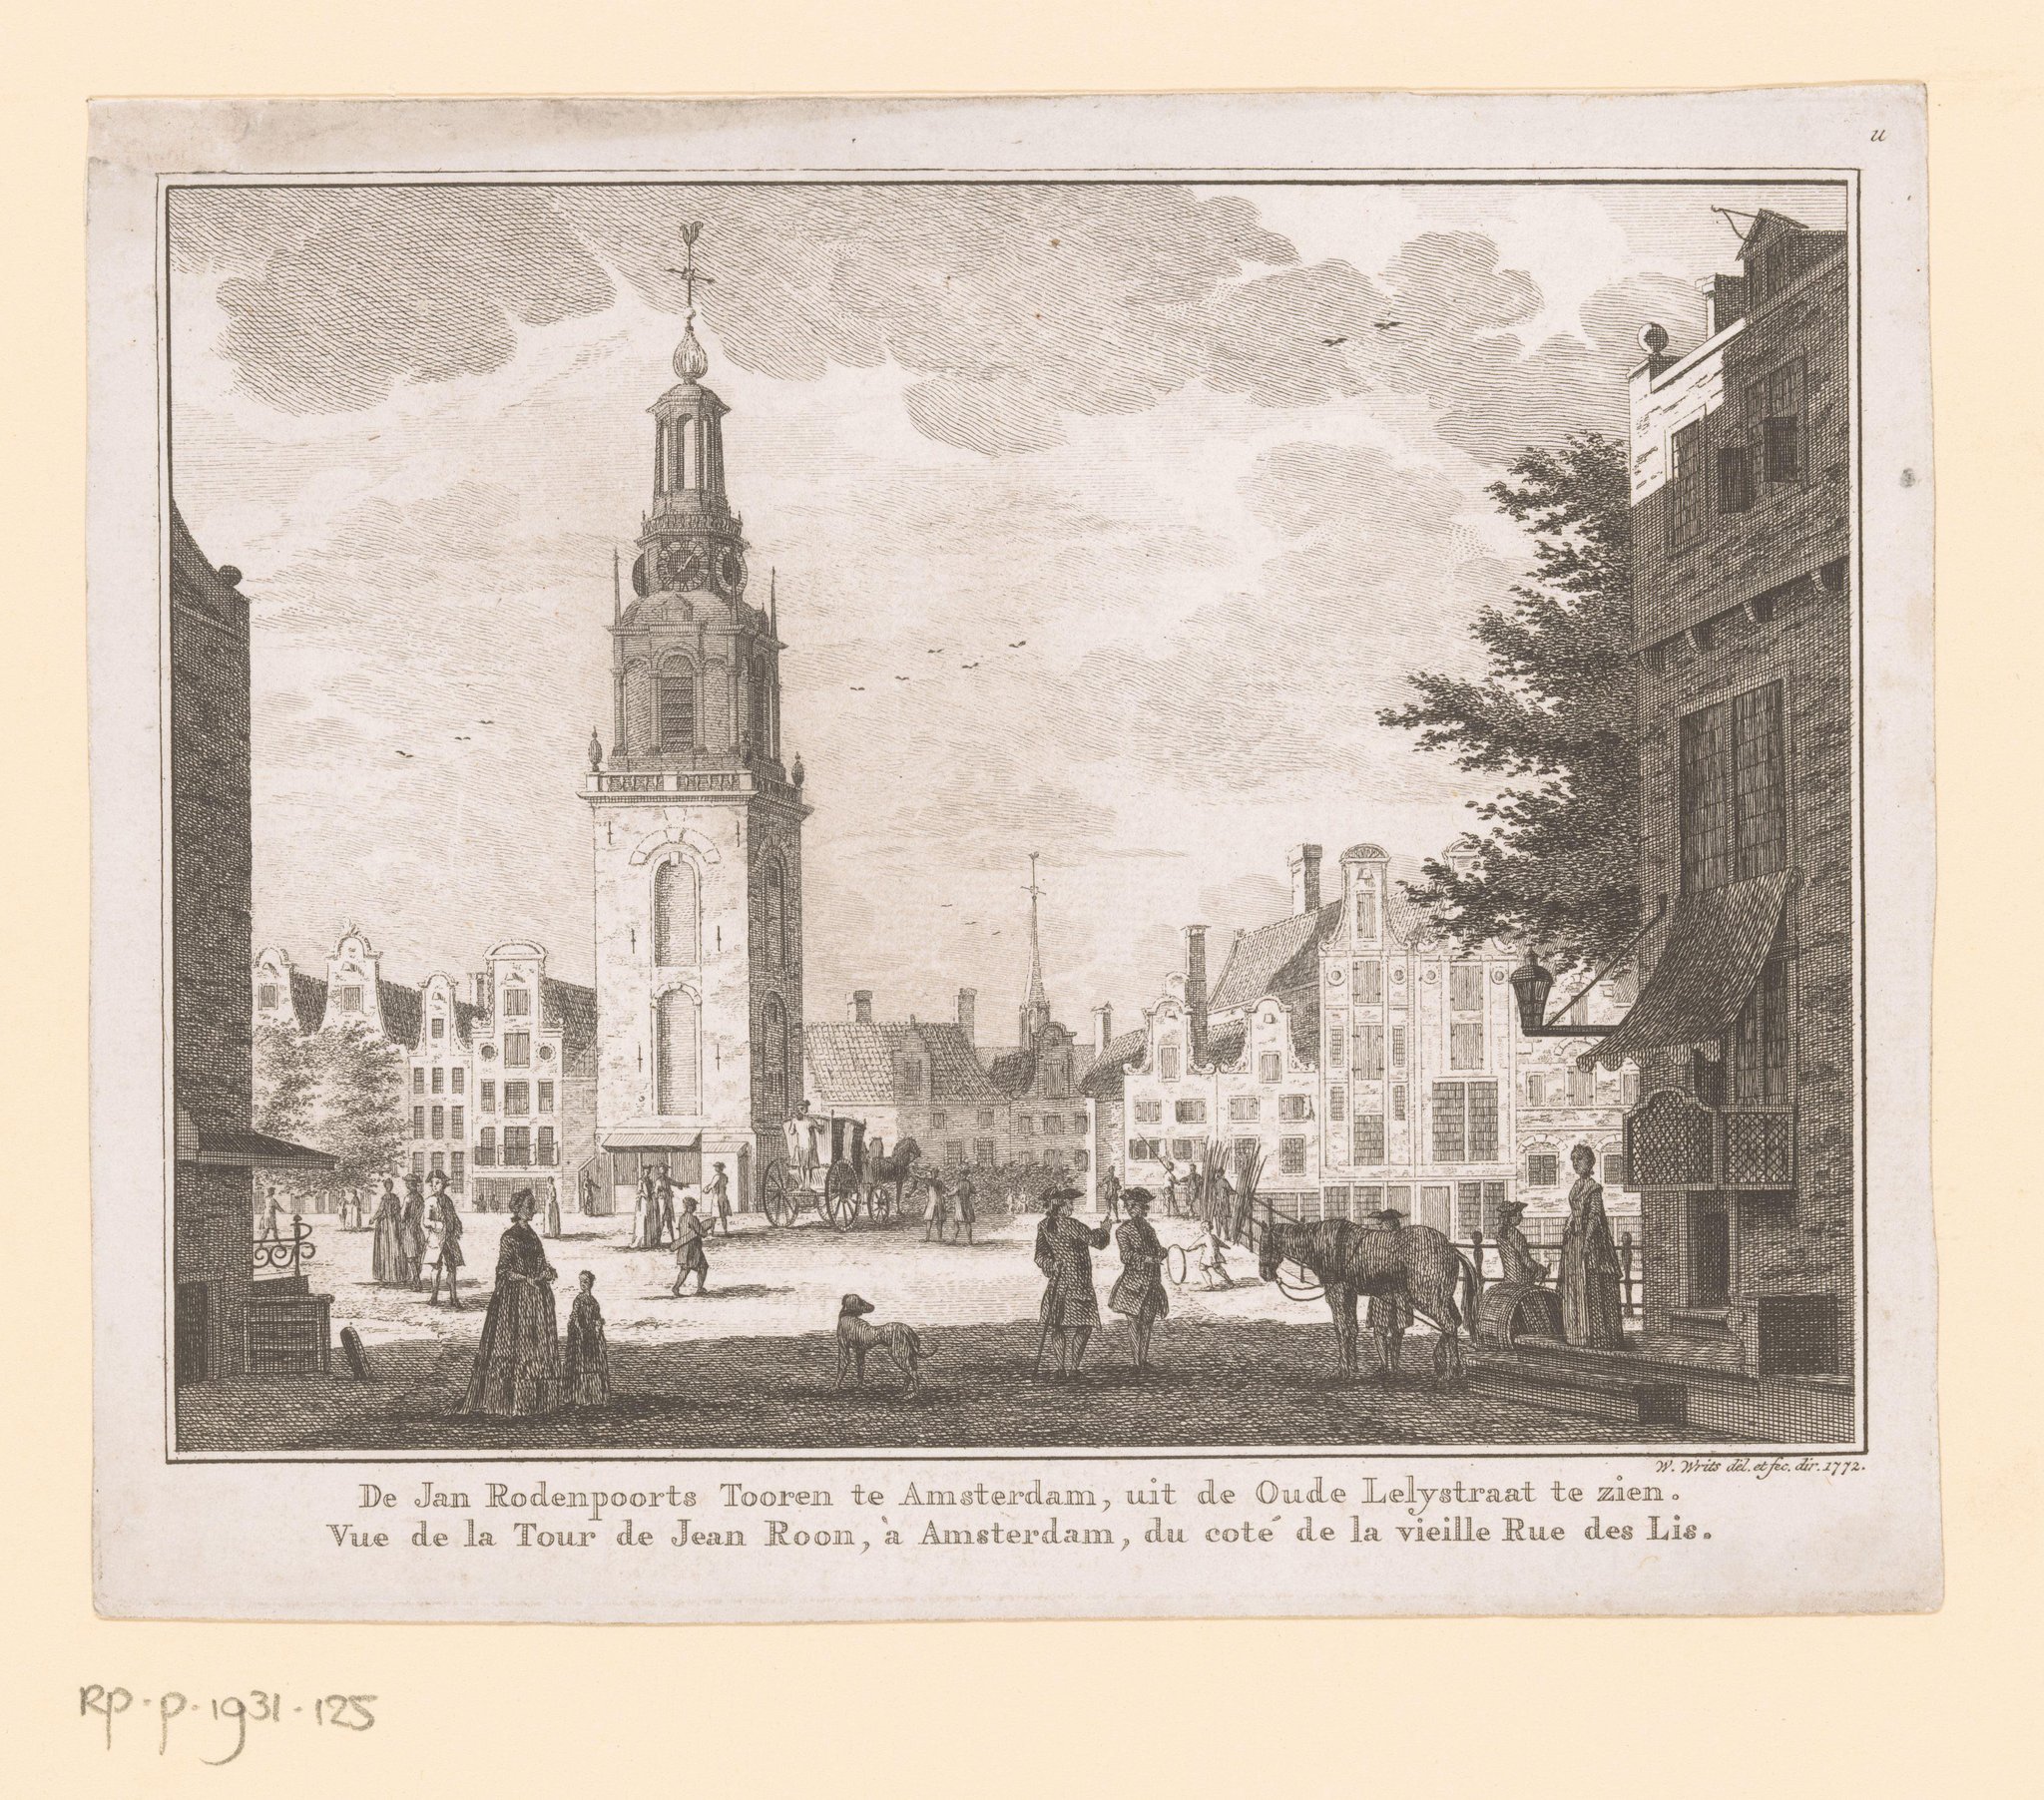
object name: book illustration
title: De Jan Rodenpoorts tooren te Amsterdam, uit de Oude Lelystraat te zien / Vue de la tour de Jean Roon, à Amsterdam, du coté de la vieille Rue des Lis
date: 1804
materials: paper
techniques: etching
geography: amsterdam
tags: urban housing, towers ~ fortified city, four-wheeled vehicle drawn by two animals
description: Prent uit: Elwe, Jan Barend. Atlas van de wereldberoemde koopstad Amsteldam (...). Amsterdam: Jan Barend Elwe, 1804.